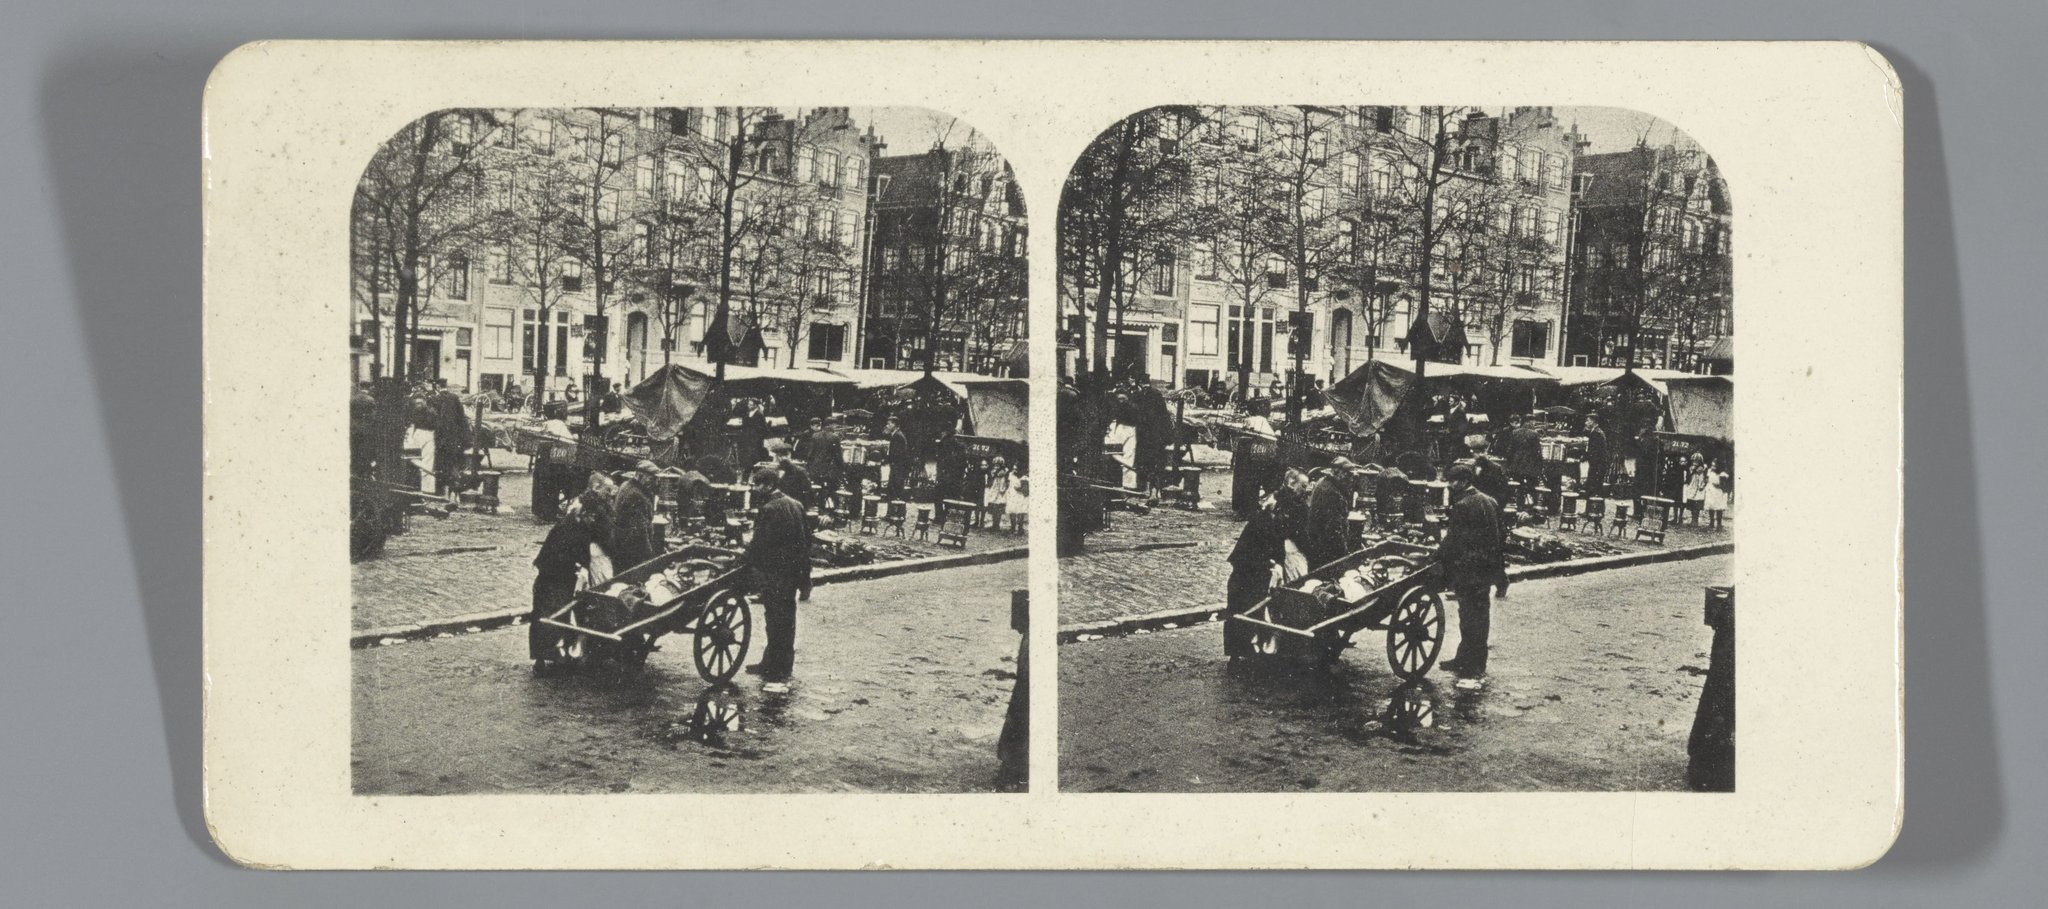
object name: stereograph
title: Waterloopleinmarkt, Amsterdam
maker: Anonymous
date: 1898-1930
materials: paper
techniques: photograph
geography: amsterdam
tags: market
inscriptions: number: ‘6’